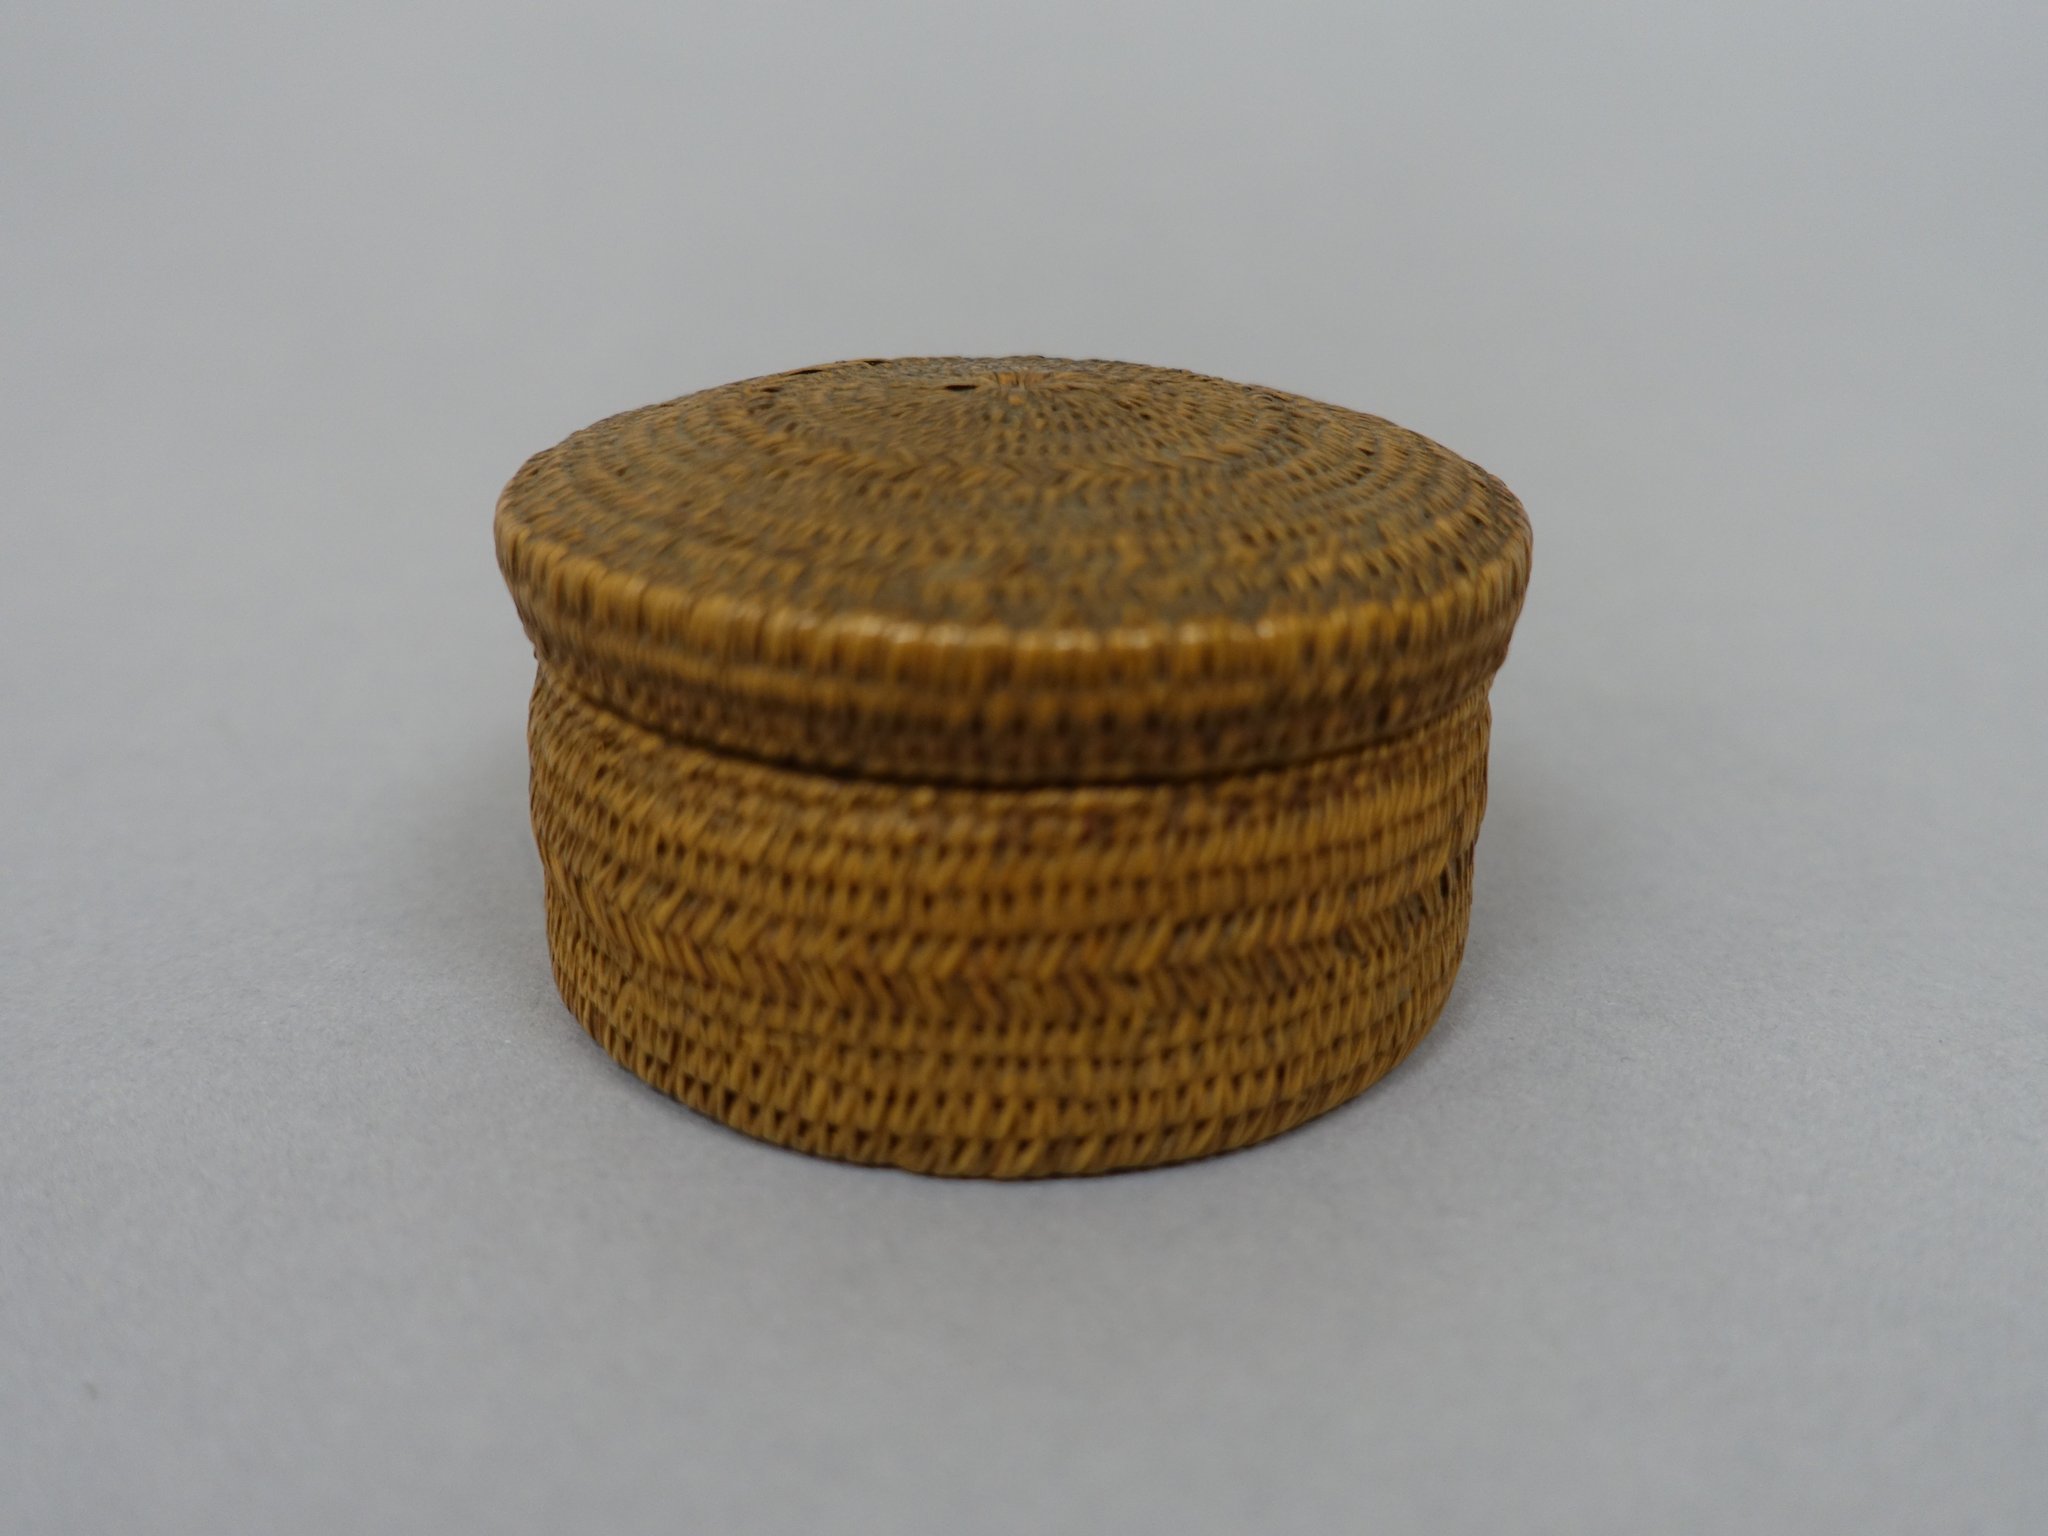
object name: covered box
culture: japanese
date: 1801-1900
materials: bamboo